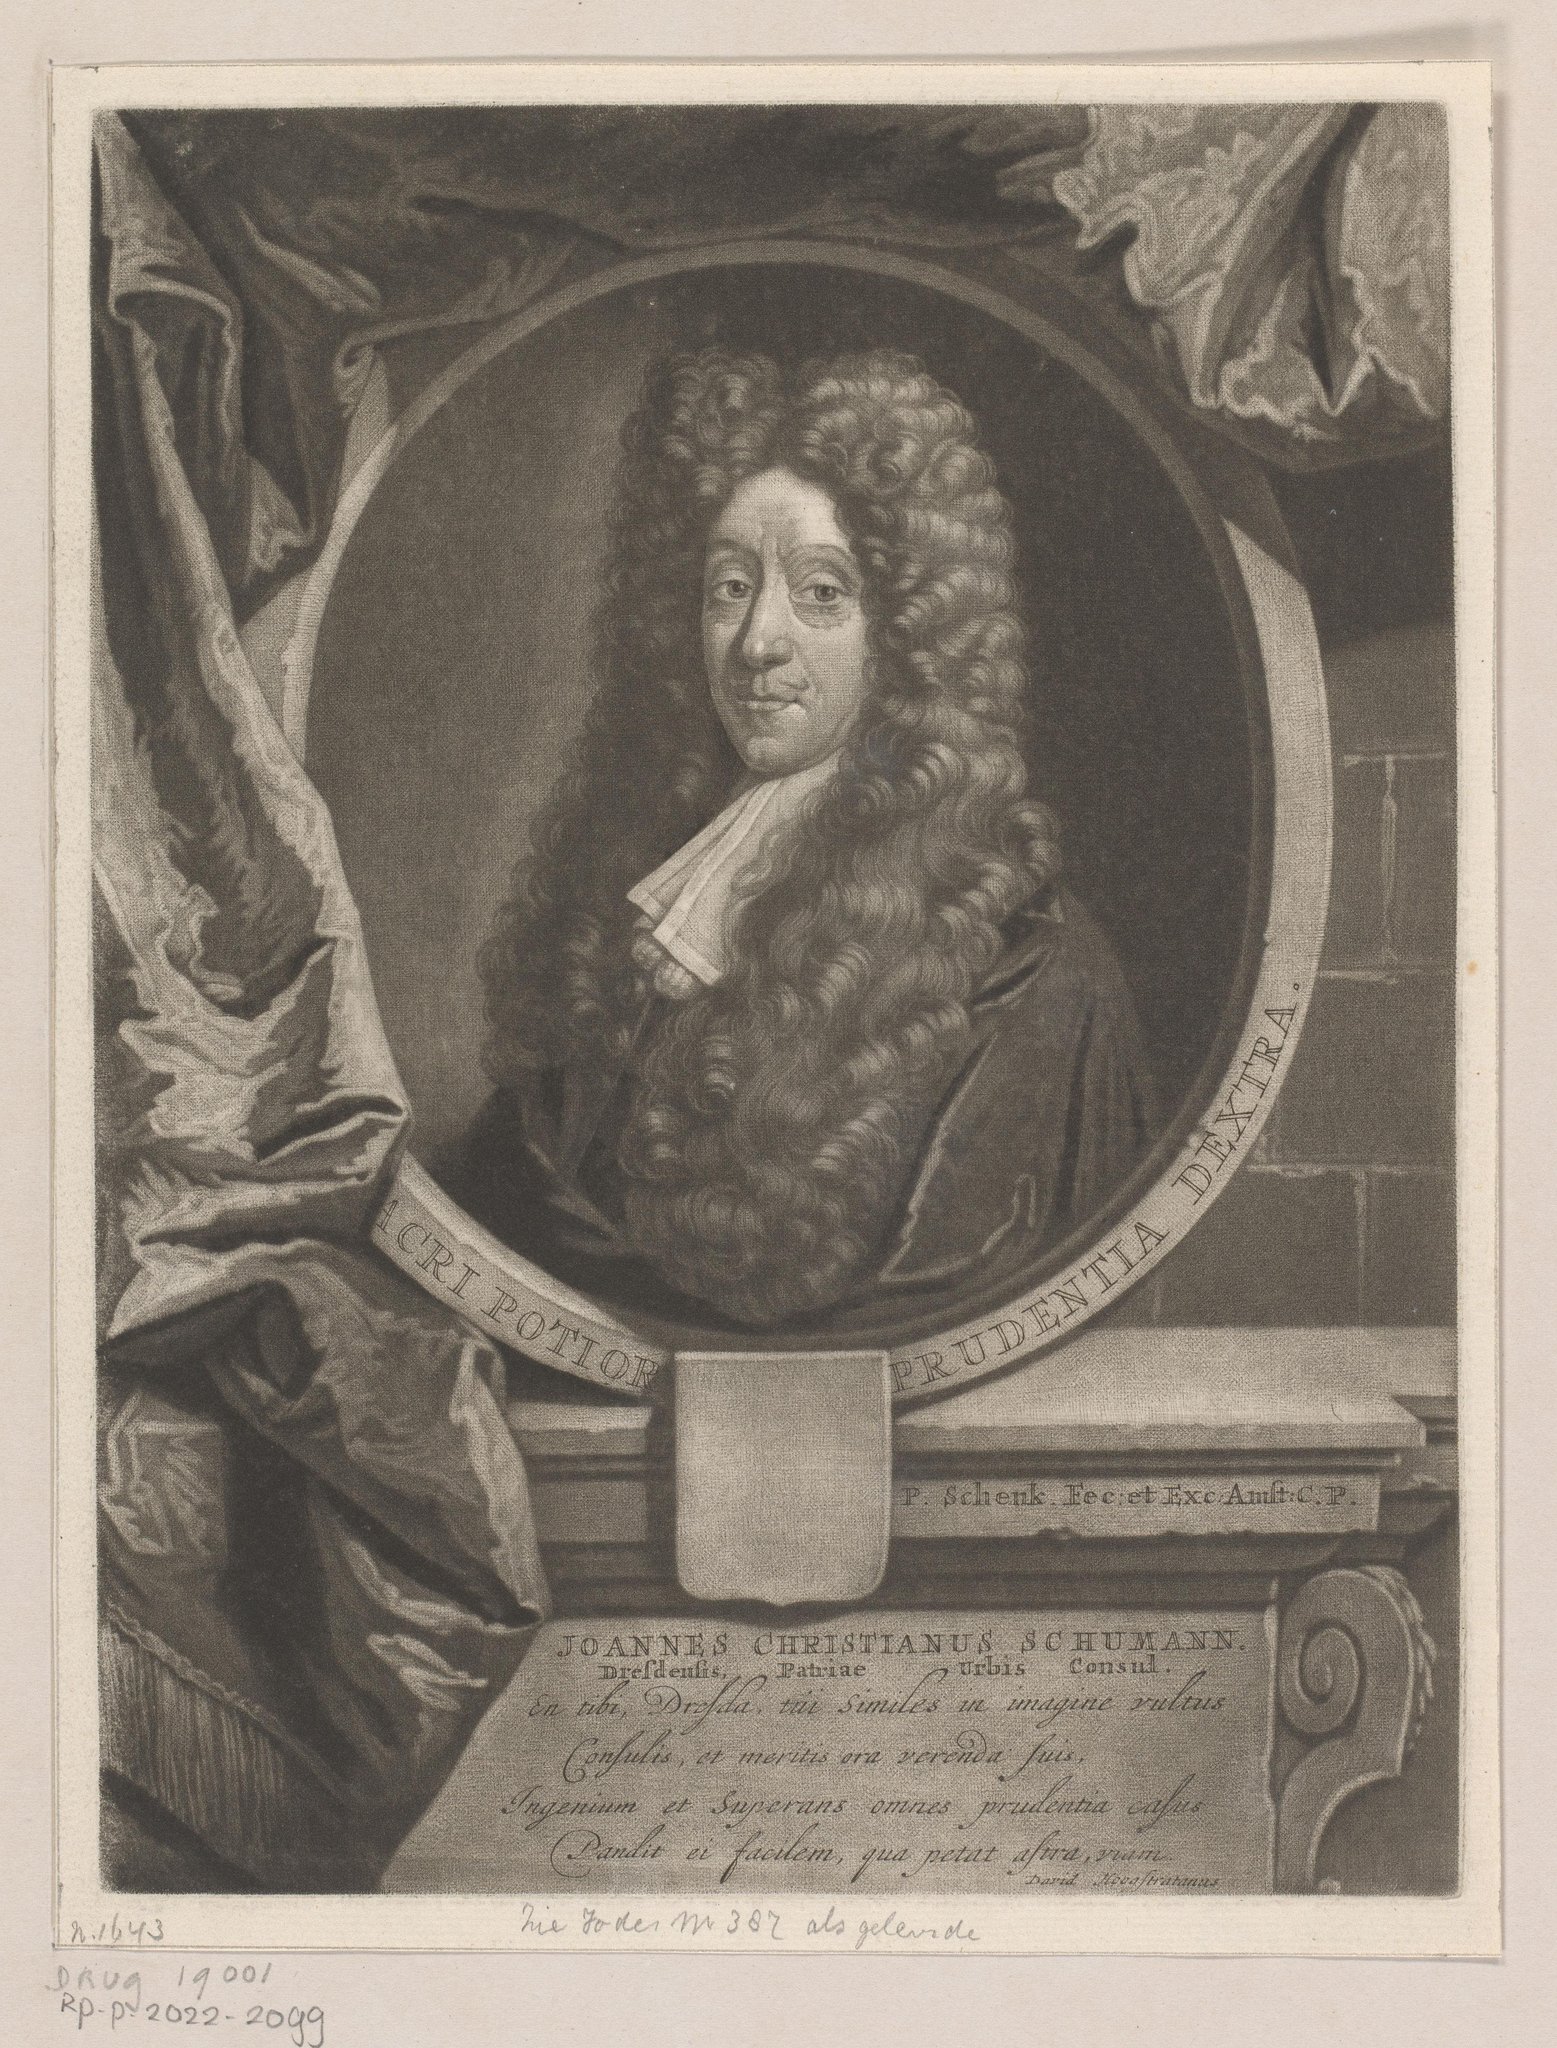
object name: print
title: Portret van Johann Christian Schumann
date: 1670-1713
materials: paper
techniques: engraving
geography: amsterdam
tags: mayor, johann christian schumann, mayor, burgomaster, historical persons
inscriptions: number: ‘No 556’, collector's mark: Lugt 2166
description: Met zesregelig onderschrift in het Latijn en tekst in het Latijn rondom het portret.